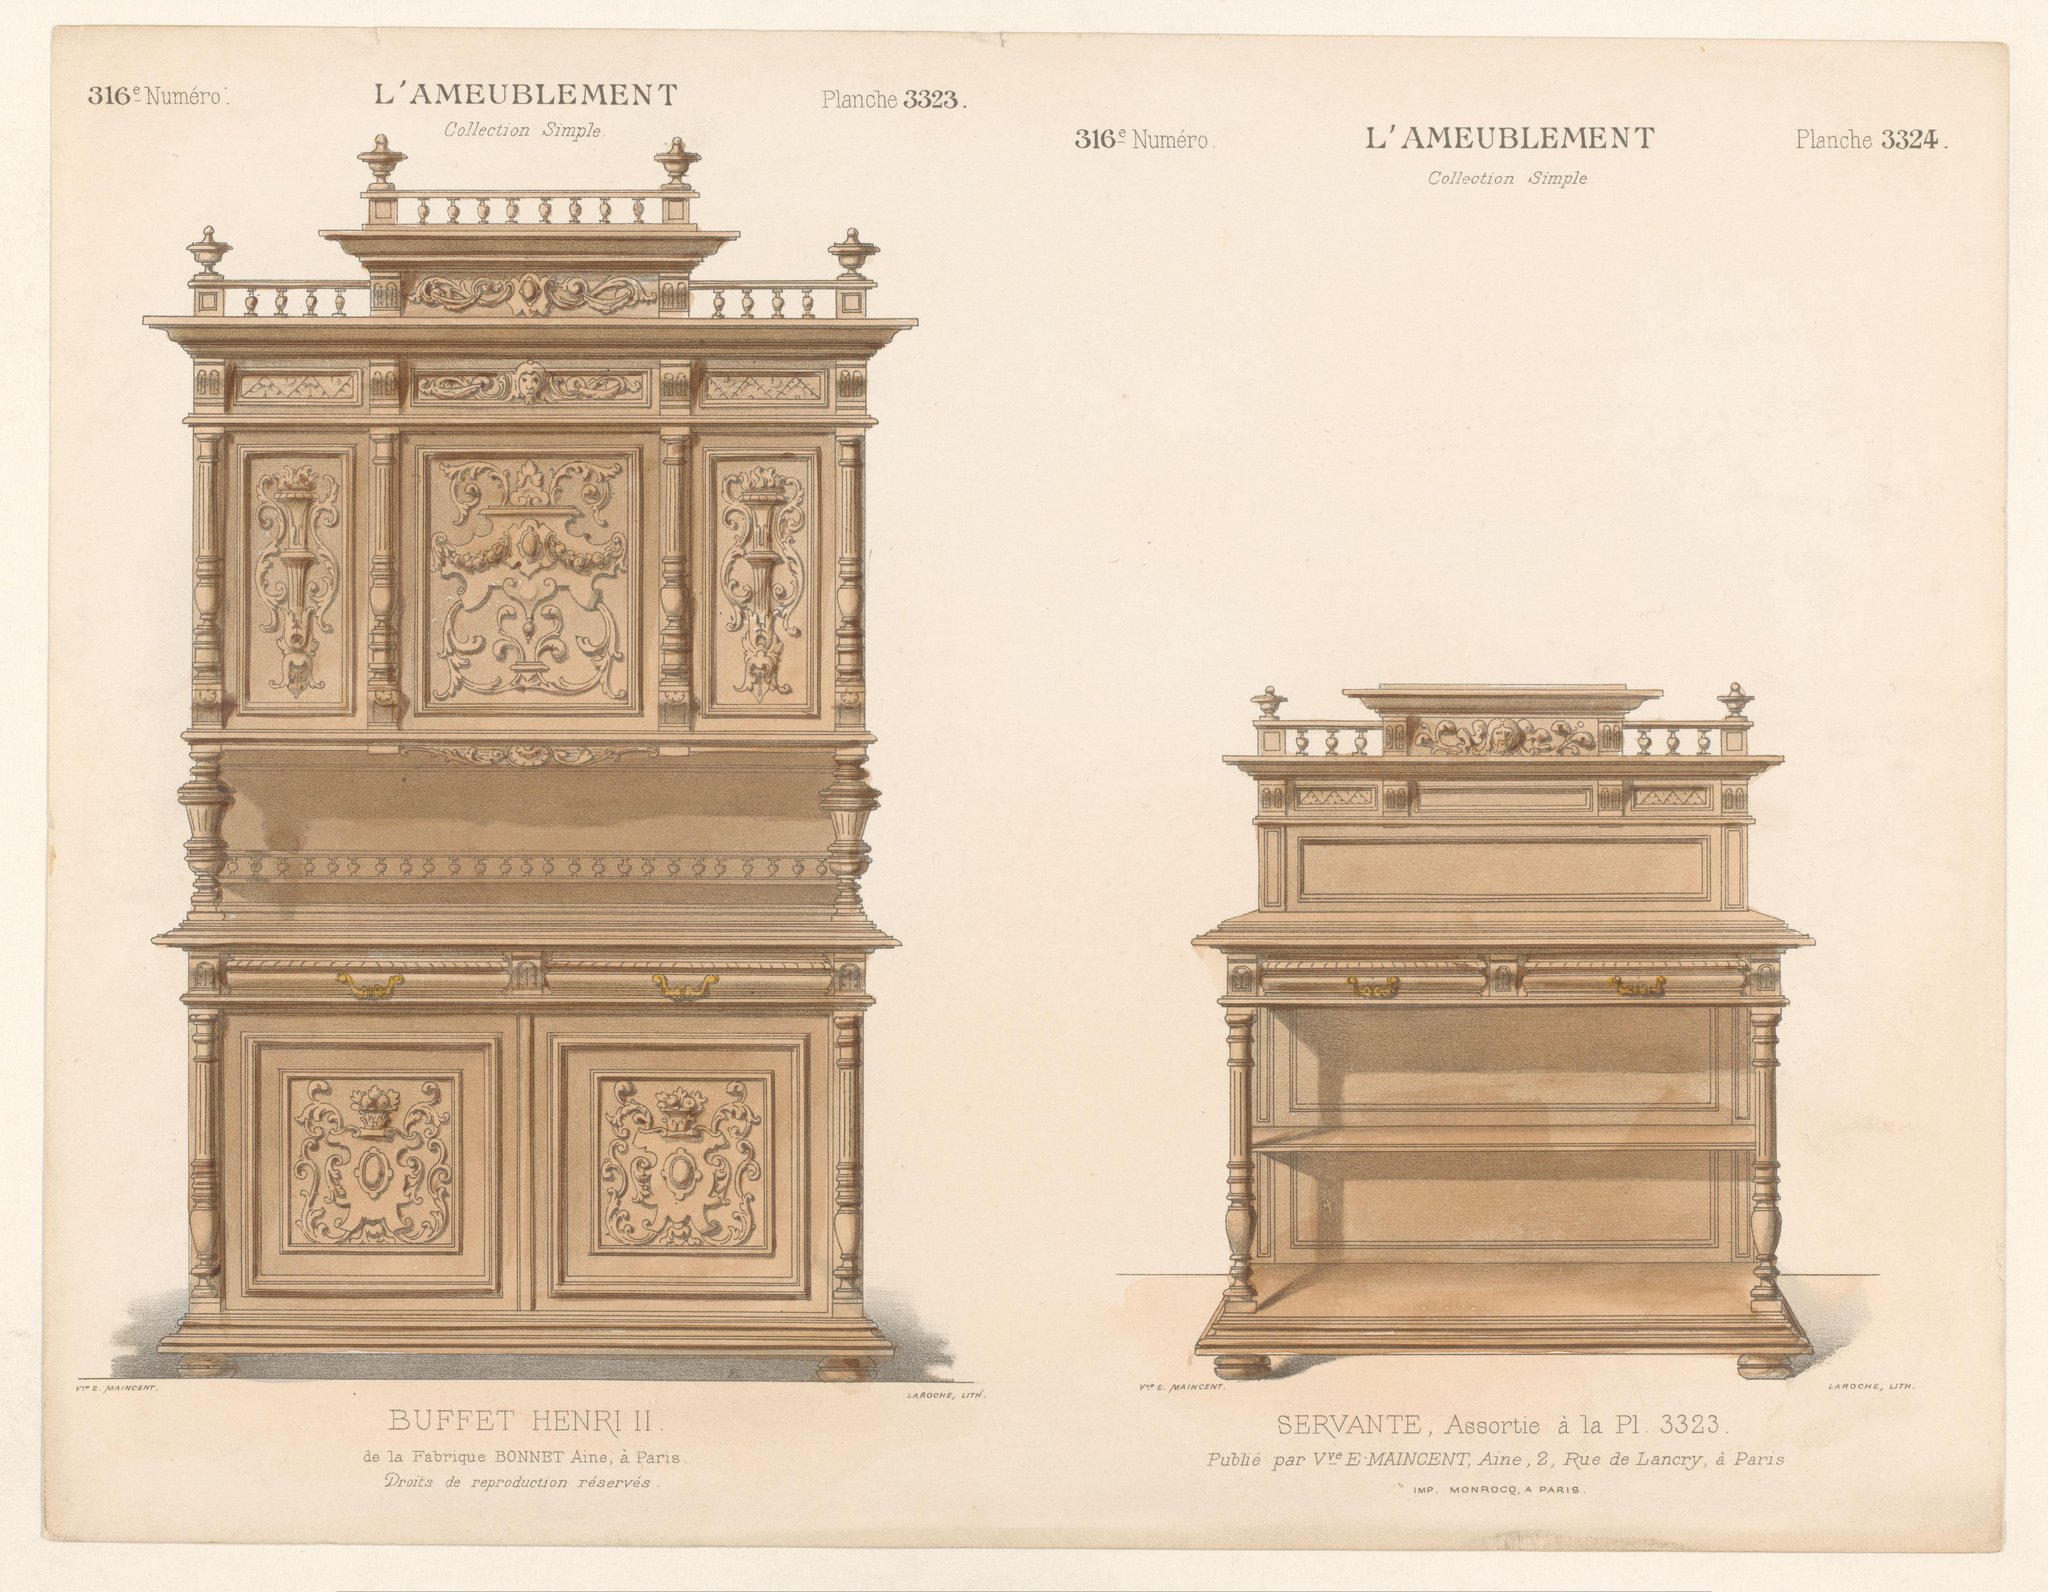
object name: print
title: Buffet Henri II / Servante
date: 1895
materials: paper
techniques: hand coloring, lithograph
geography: paris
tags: furniture for storage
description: Een buffetkast en lage open kast in de Hendrik II-stijl. Prent uit 316e Livraison.